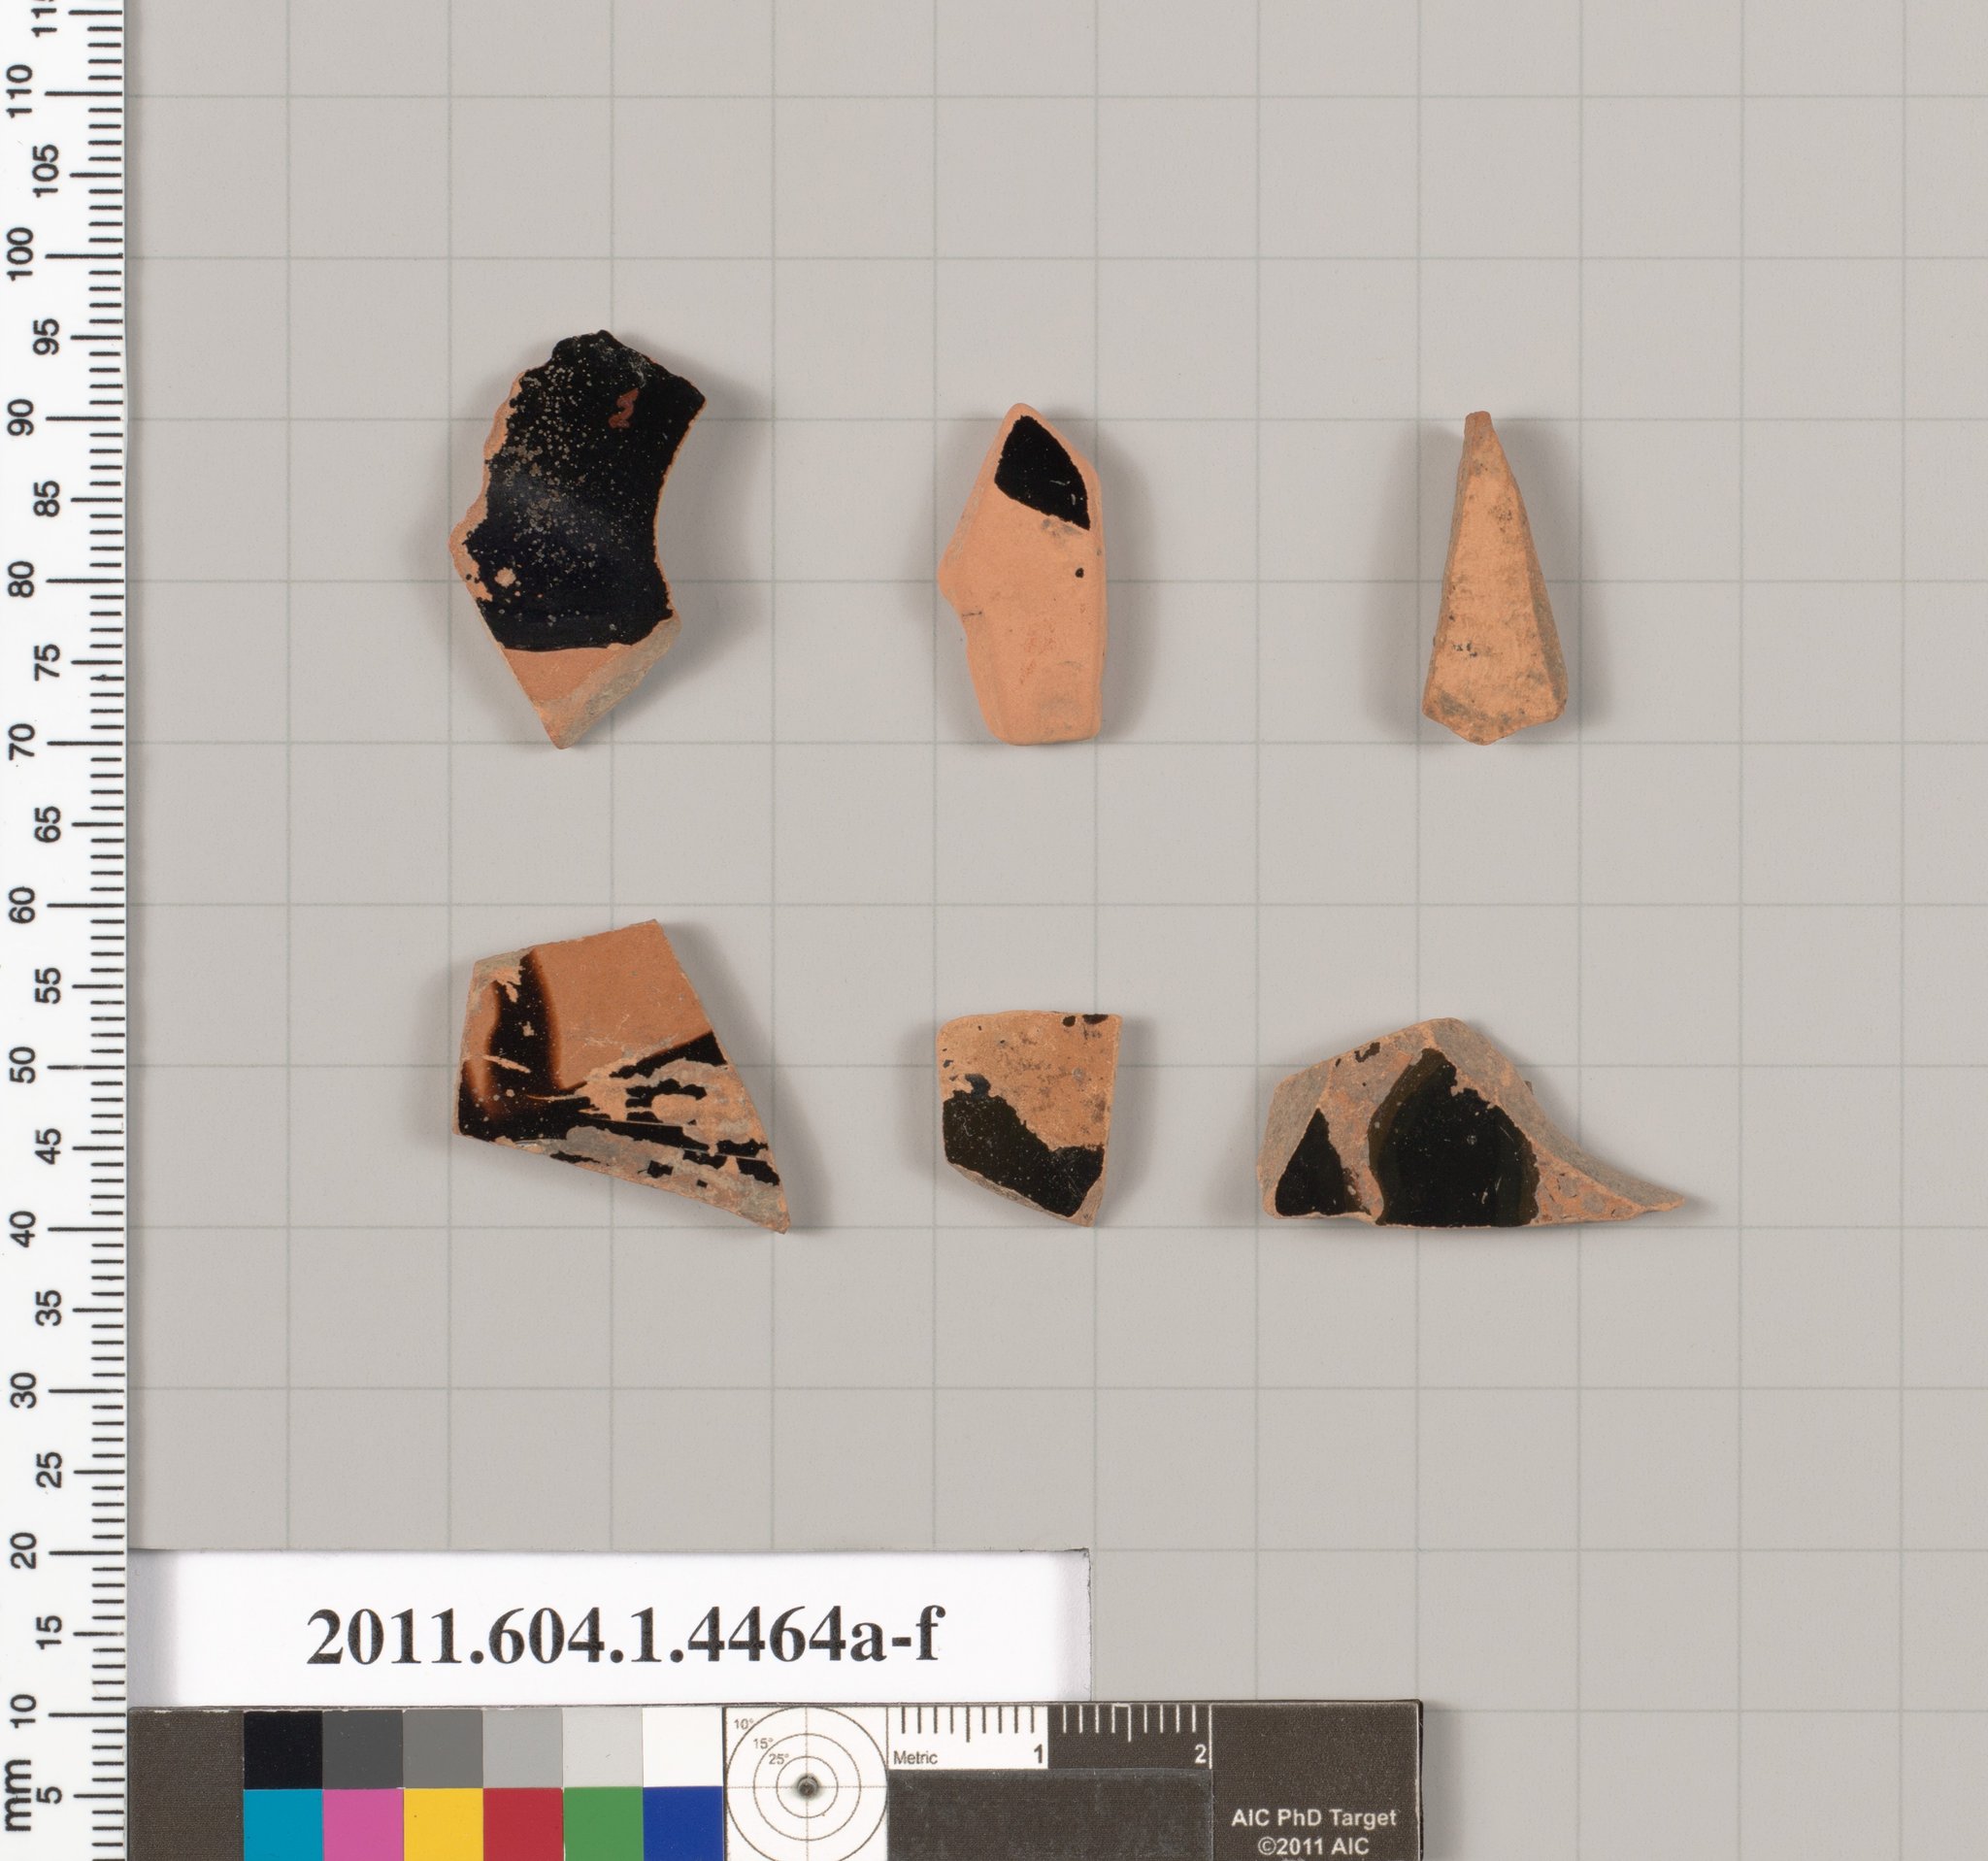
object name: kylix fragment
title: Terracotta fragments of kylikes (drinking cups)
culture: greek, attic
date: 500-451 BCE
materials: terracotta